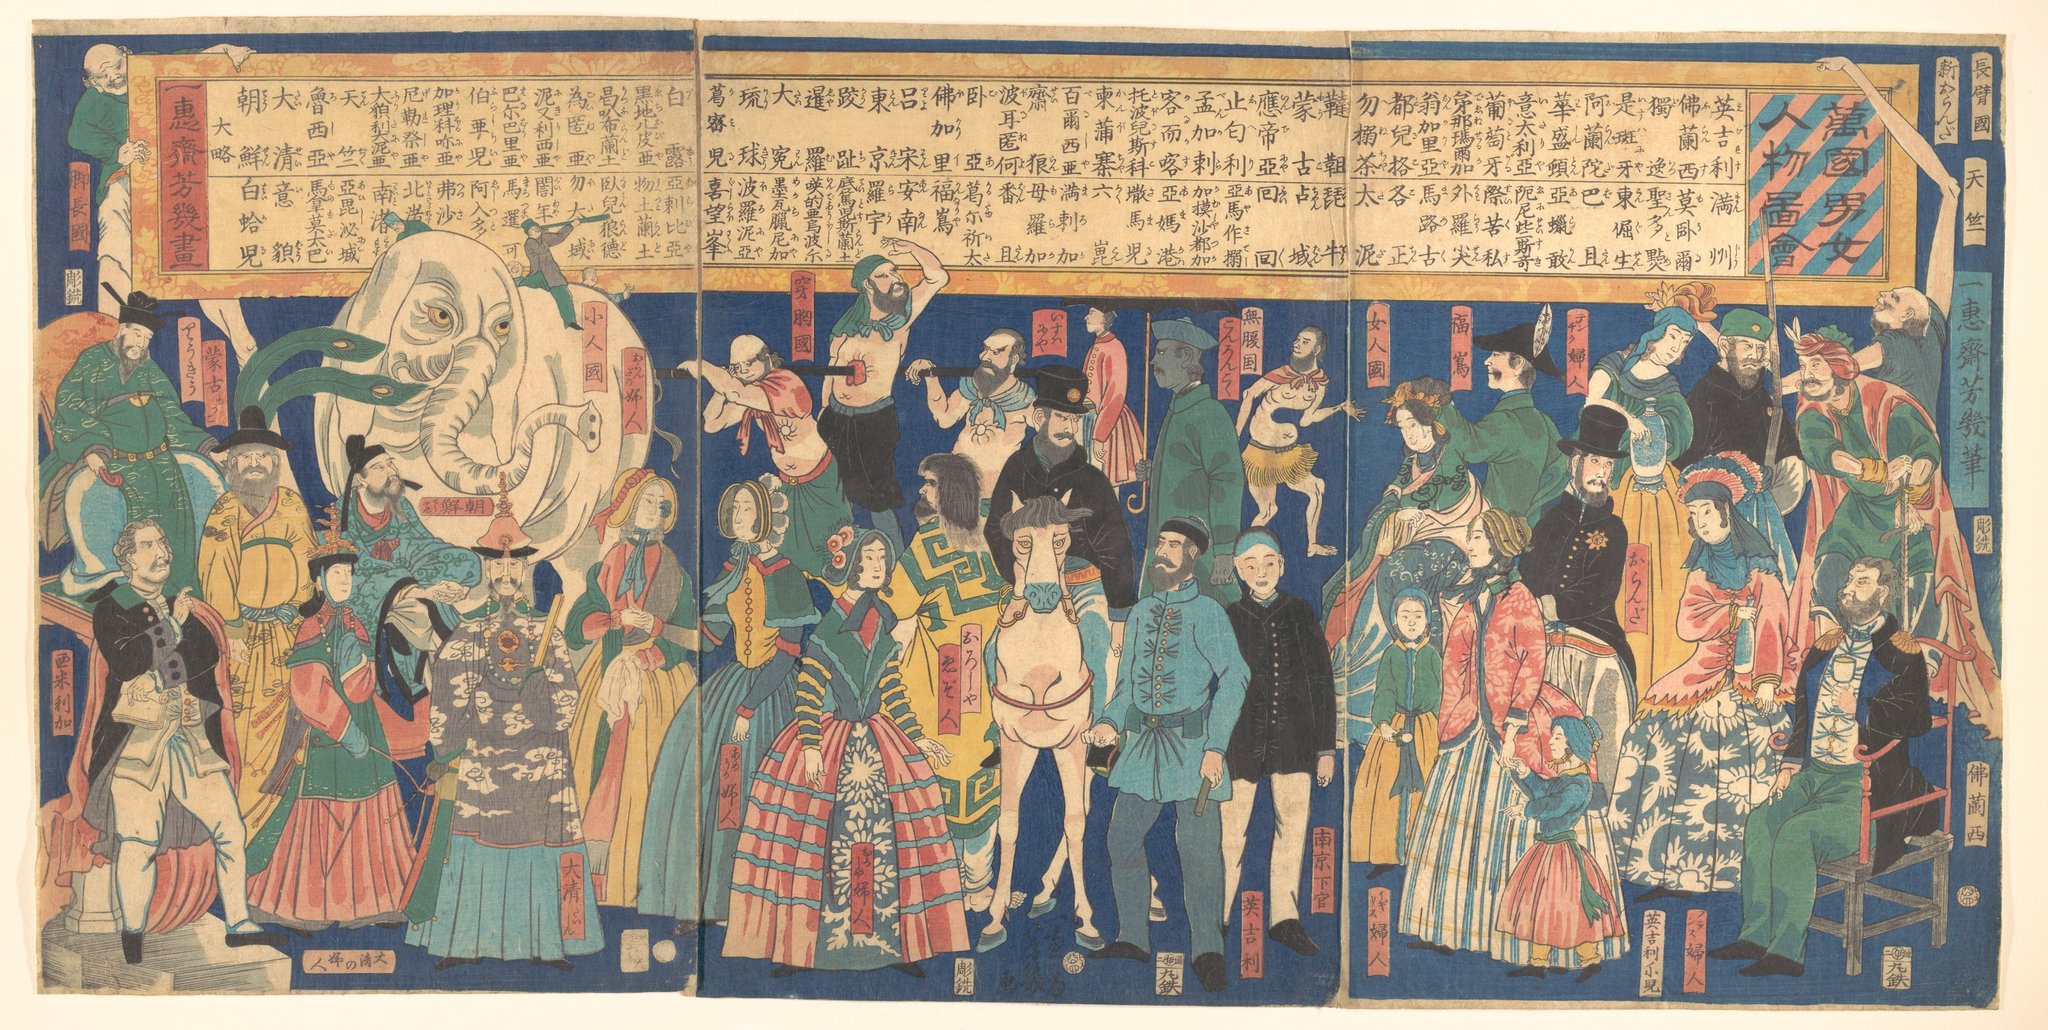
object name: print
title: Picture of Men and Women from all nations (Bankoku danjo jinbutsu zue)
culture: japanese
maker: utagawa yoshiiku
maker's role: artist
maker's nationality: japanese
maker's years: 1833-1904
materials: ink, paper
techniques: woodblock print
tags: men,women,elephants,horses